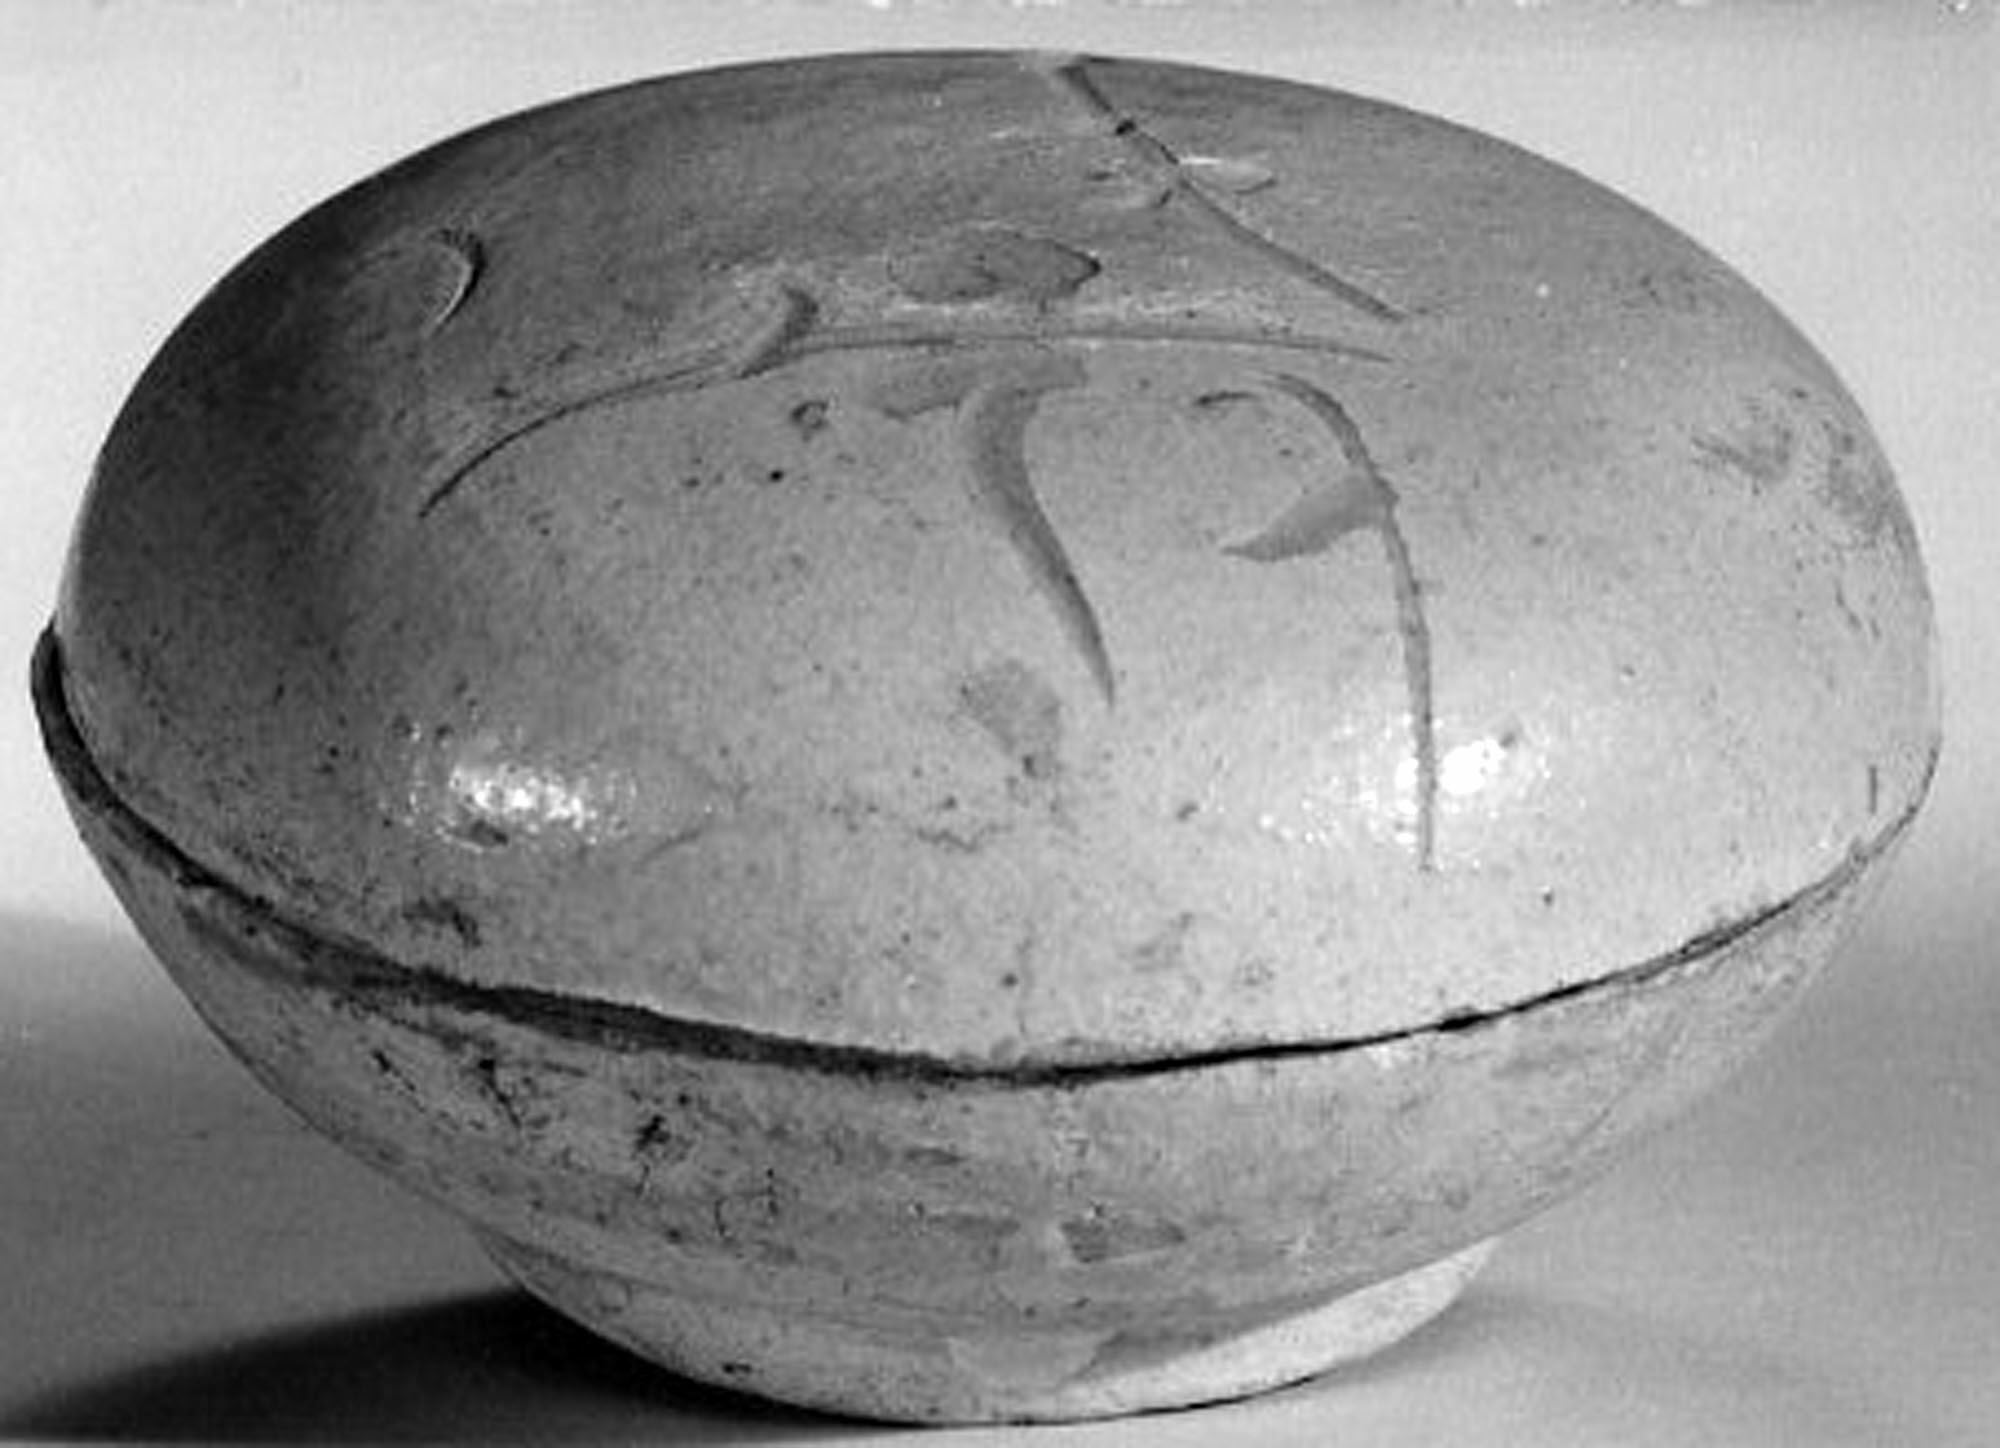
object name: box with cover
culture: chinese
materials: stoneware